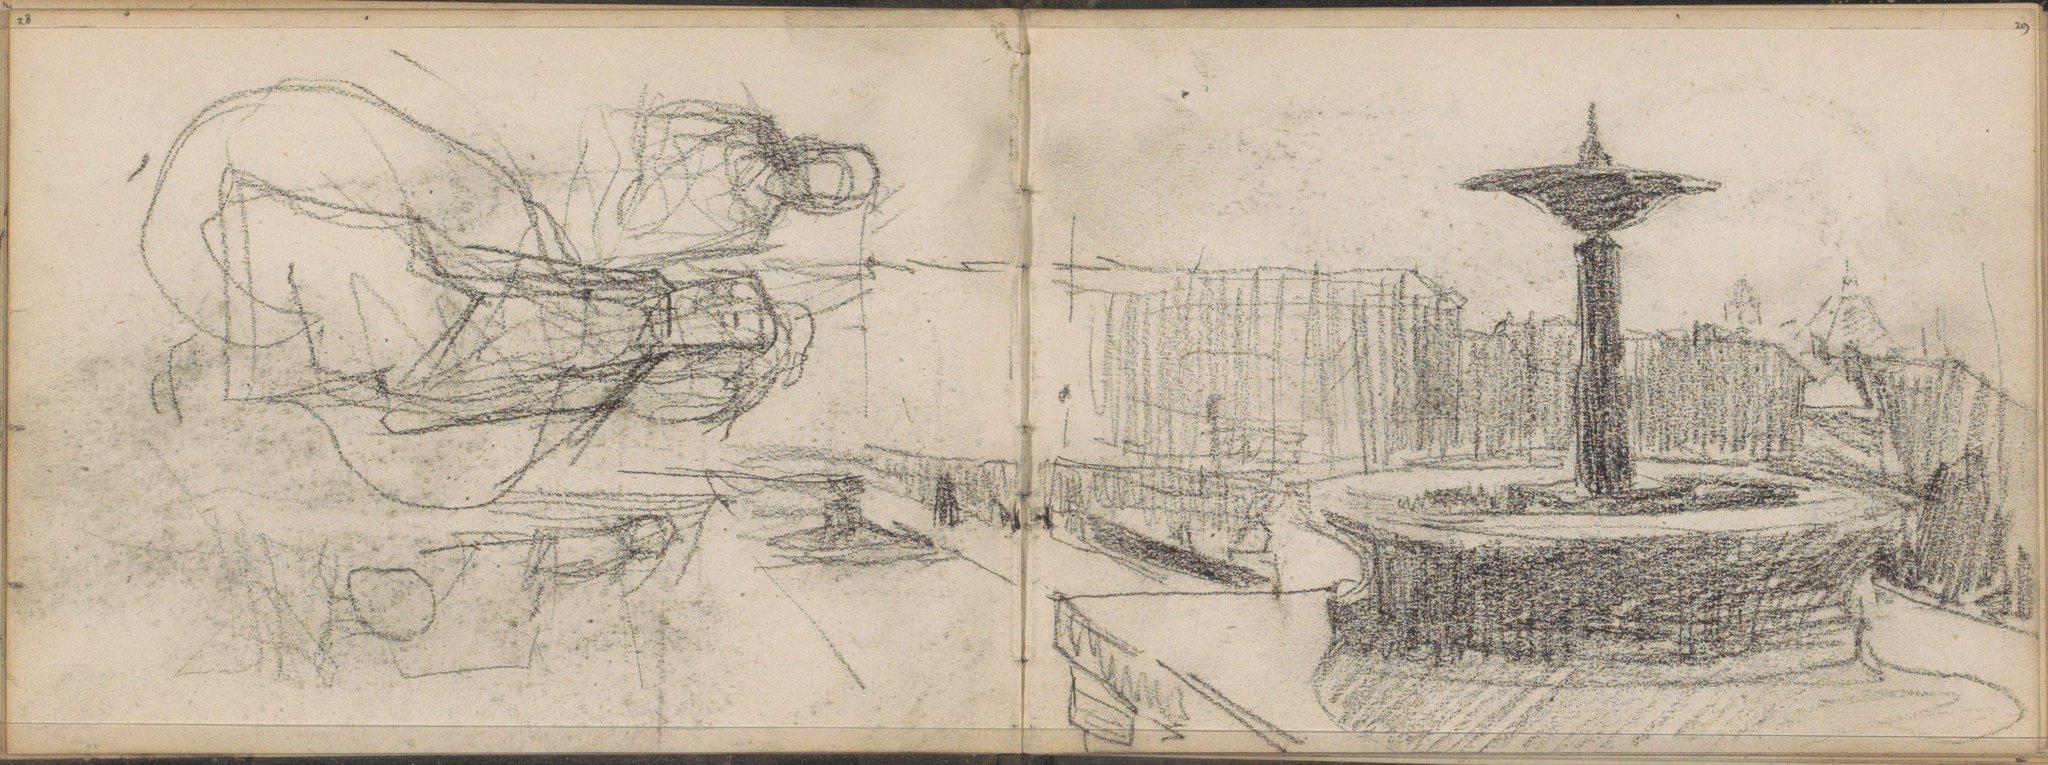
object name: sketchbook leaf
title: Stadsplein met een fontein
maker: marius bauer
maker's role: draughtsman, print maker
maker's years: 1867-1932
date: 1877-1932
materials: chalk, paper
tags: anatomy (non-medical), ornamental fountain, street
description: De fontein ligt aan een laan. Tevens enkele figuurstudies. Pagina 28 en 29 uit een schetsboek met 32 bladen.